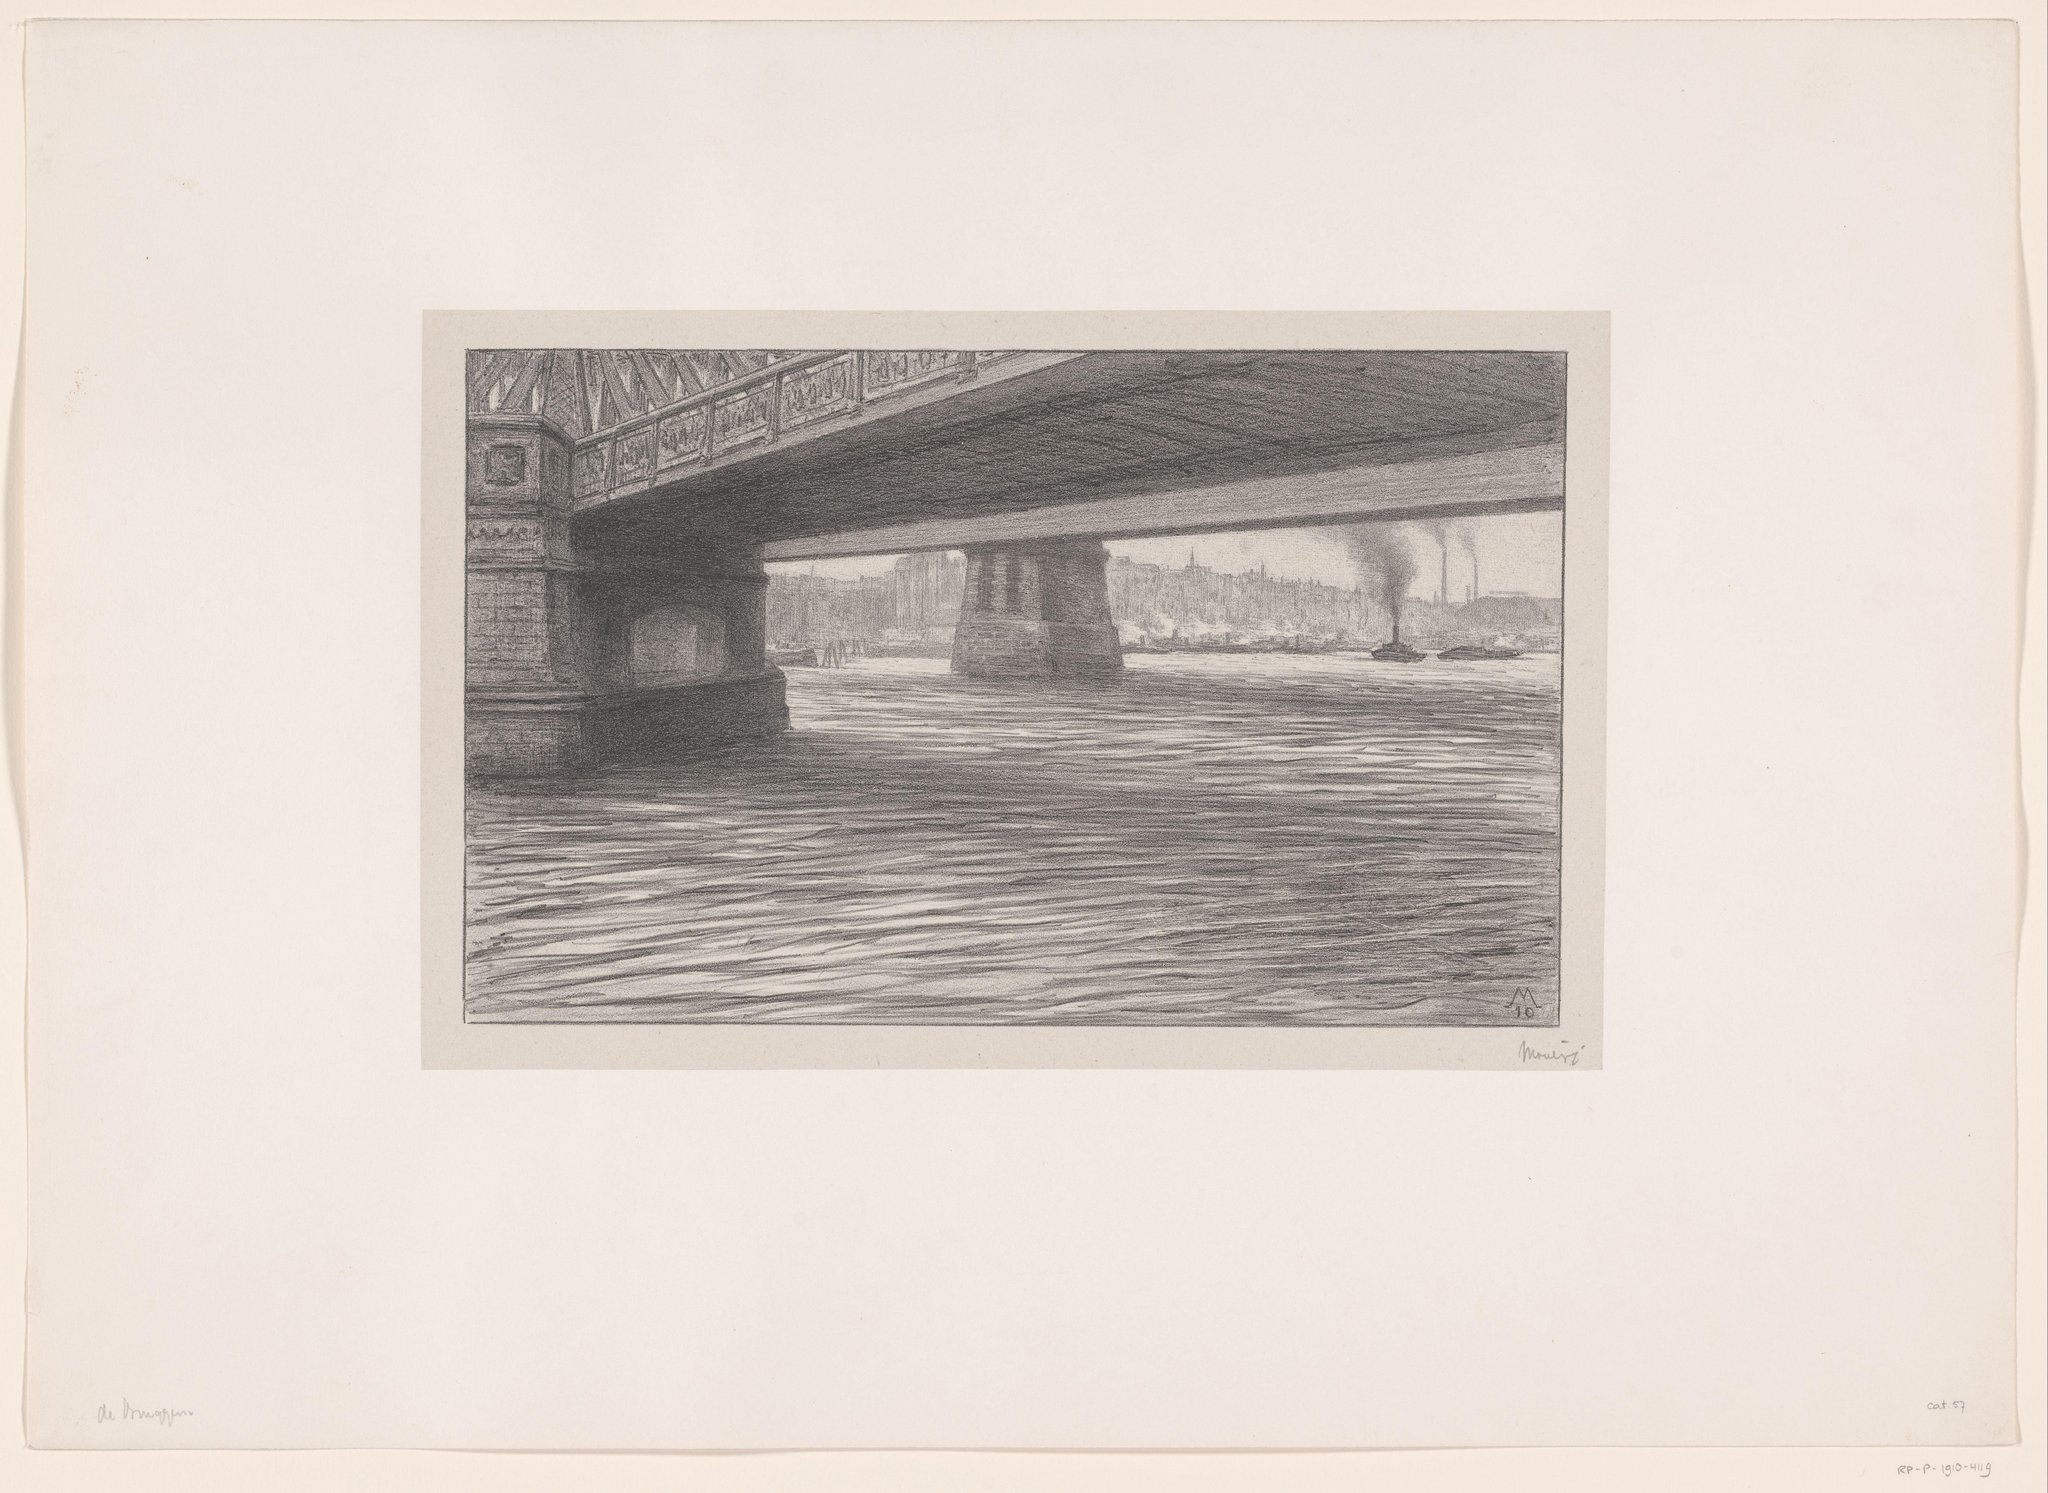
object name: print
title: De Bruggen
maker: simon moulijn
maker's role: draughtsman, print maker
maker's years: 1866-1948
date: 1910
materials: paper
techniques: lithograph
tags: bridge, rotterdam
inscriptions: annotation: ‘De Bruggen’, collector's mark: Lugt 2228